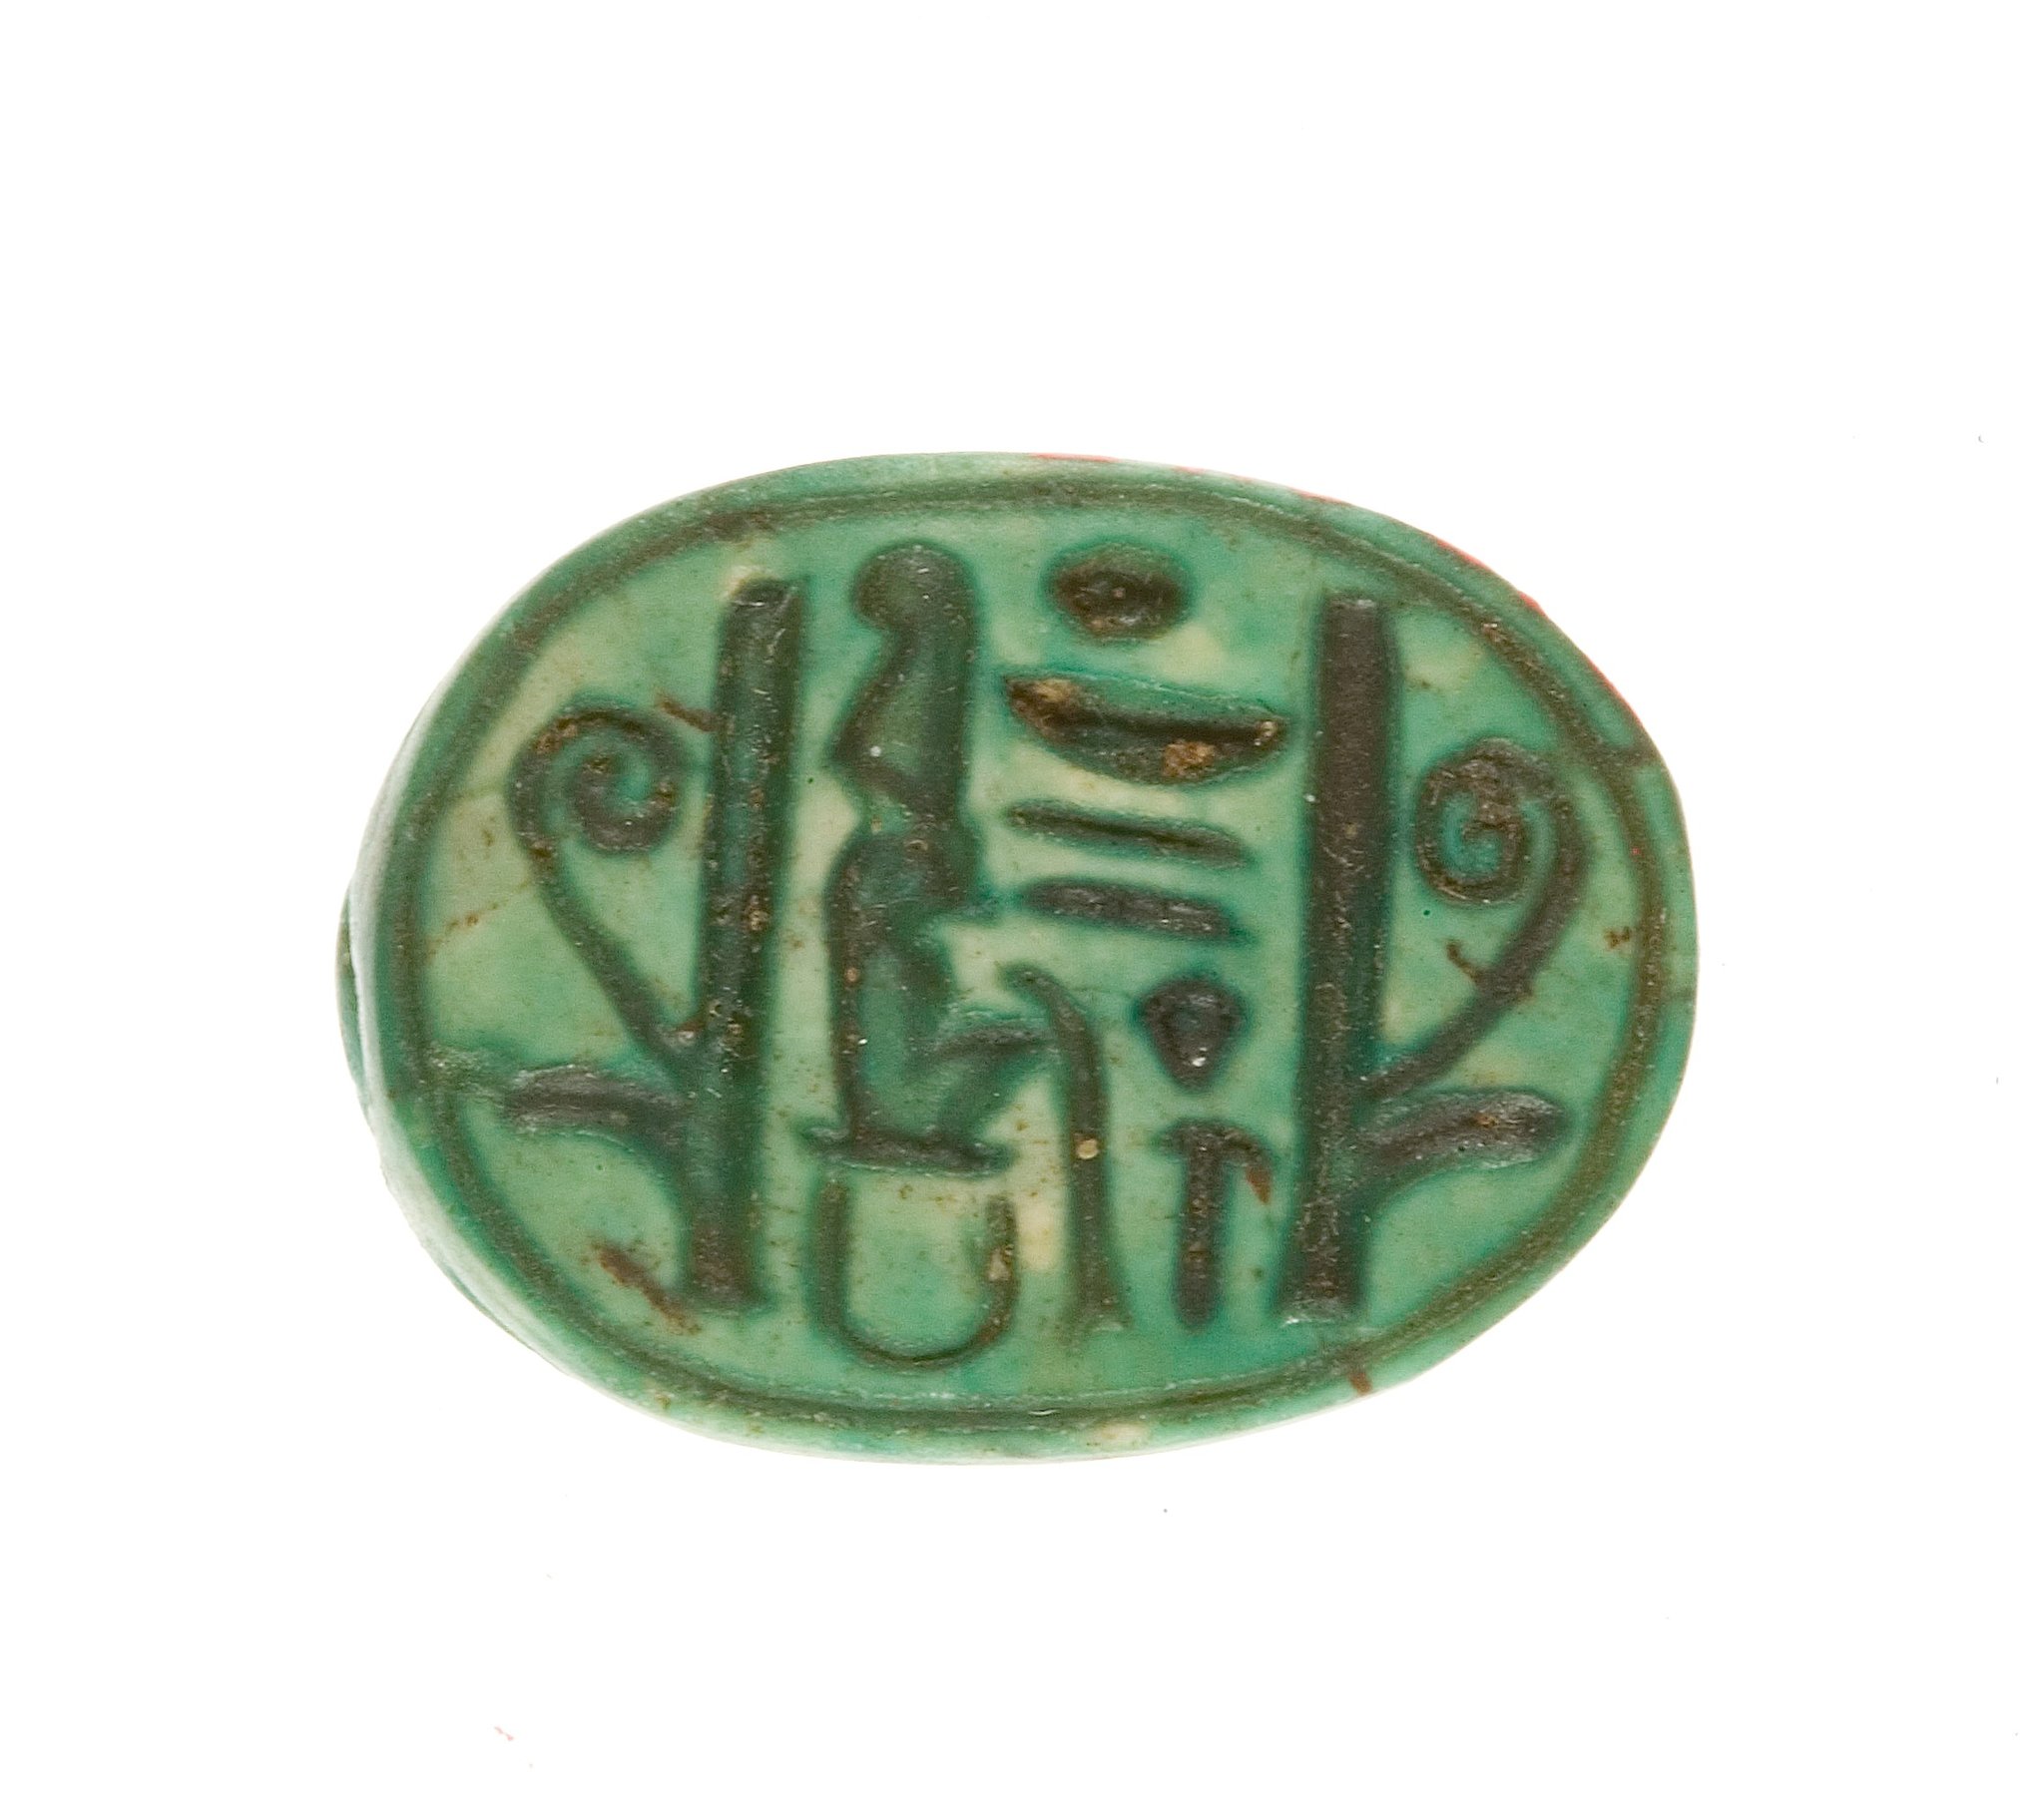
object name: scarab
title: Scarab Inscribed Lord of the Two Lands Maatkare, Living, Flanked by Two Red Crowns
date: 1479-1458 BCE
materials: stone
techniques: glazing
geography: egypt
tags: scarabs